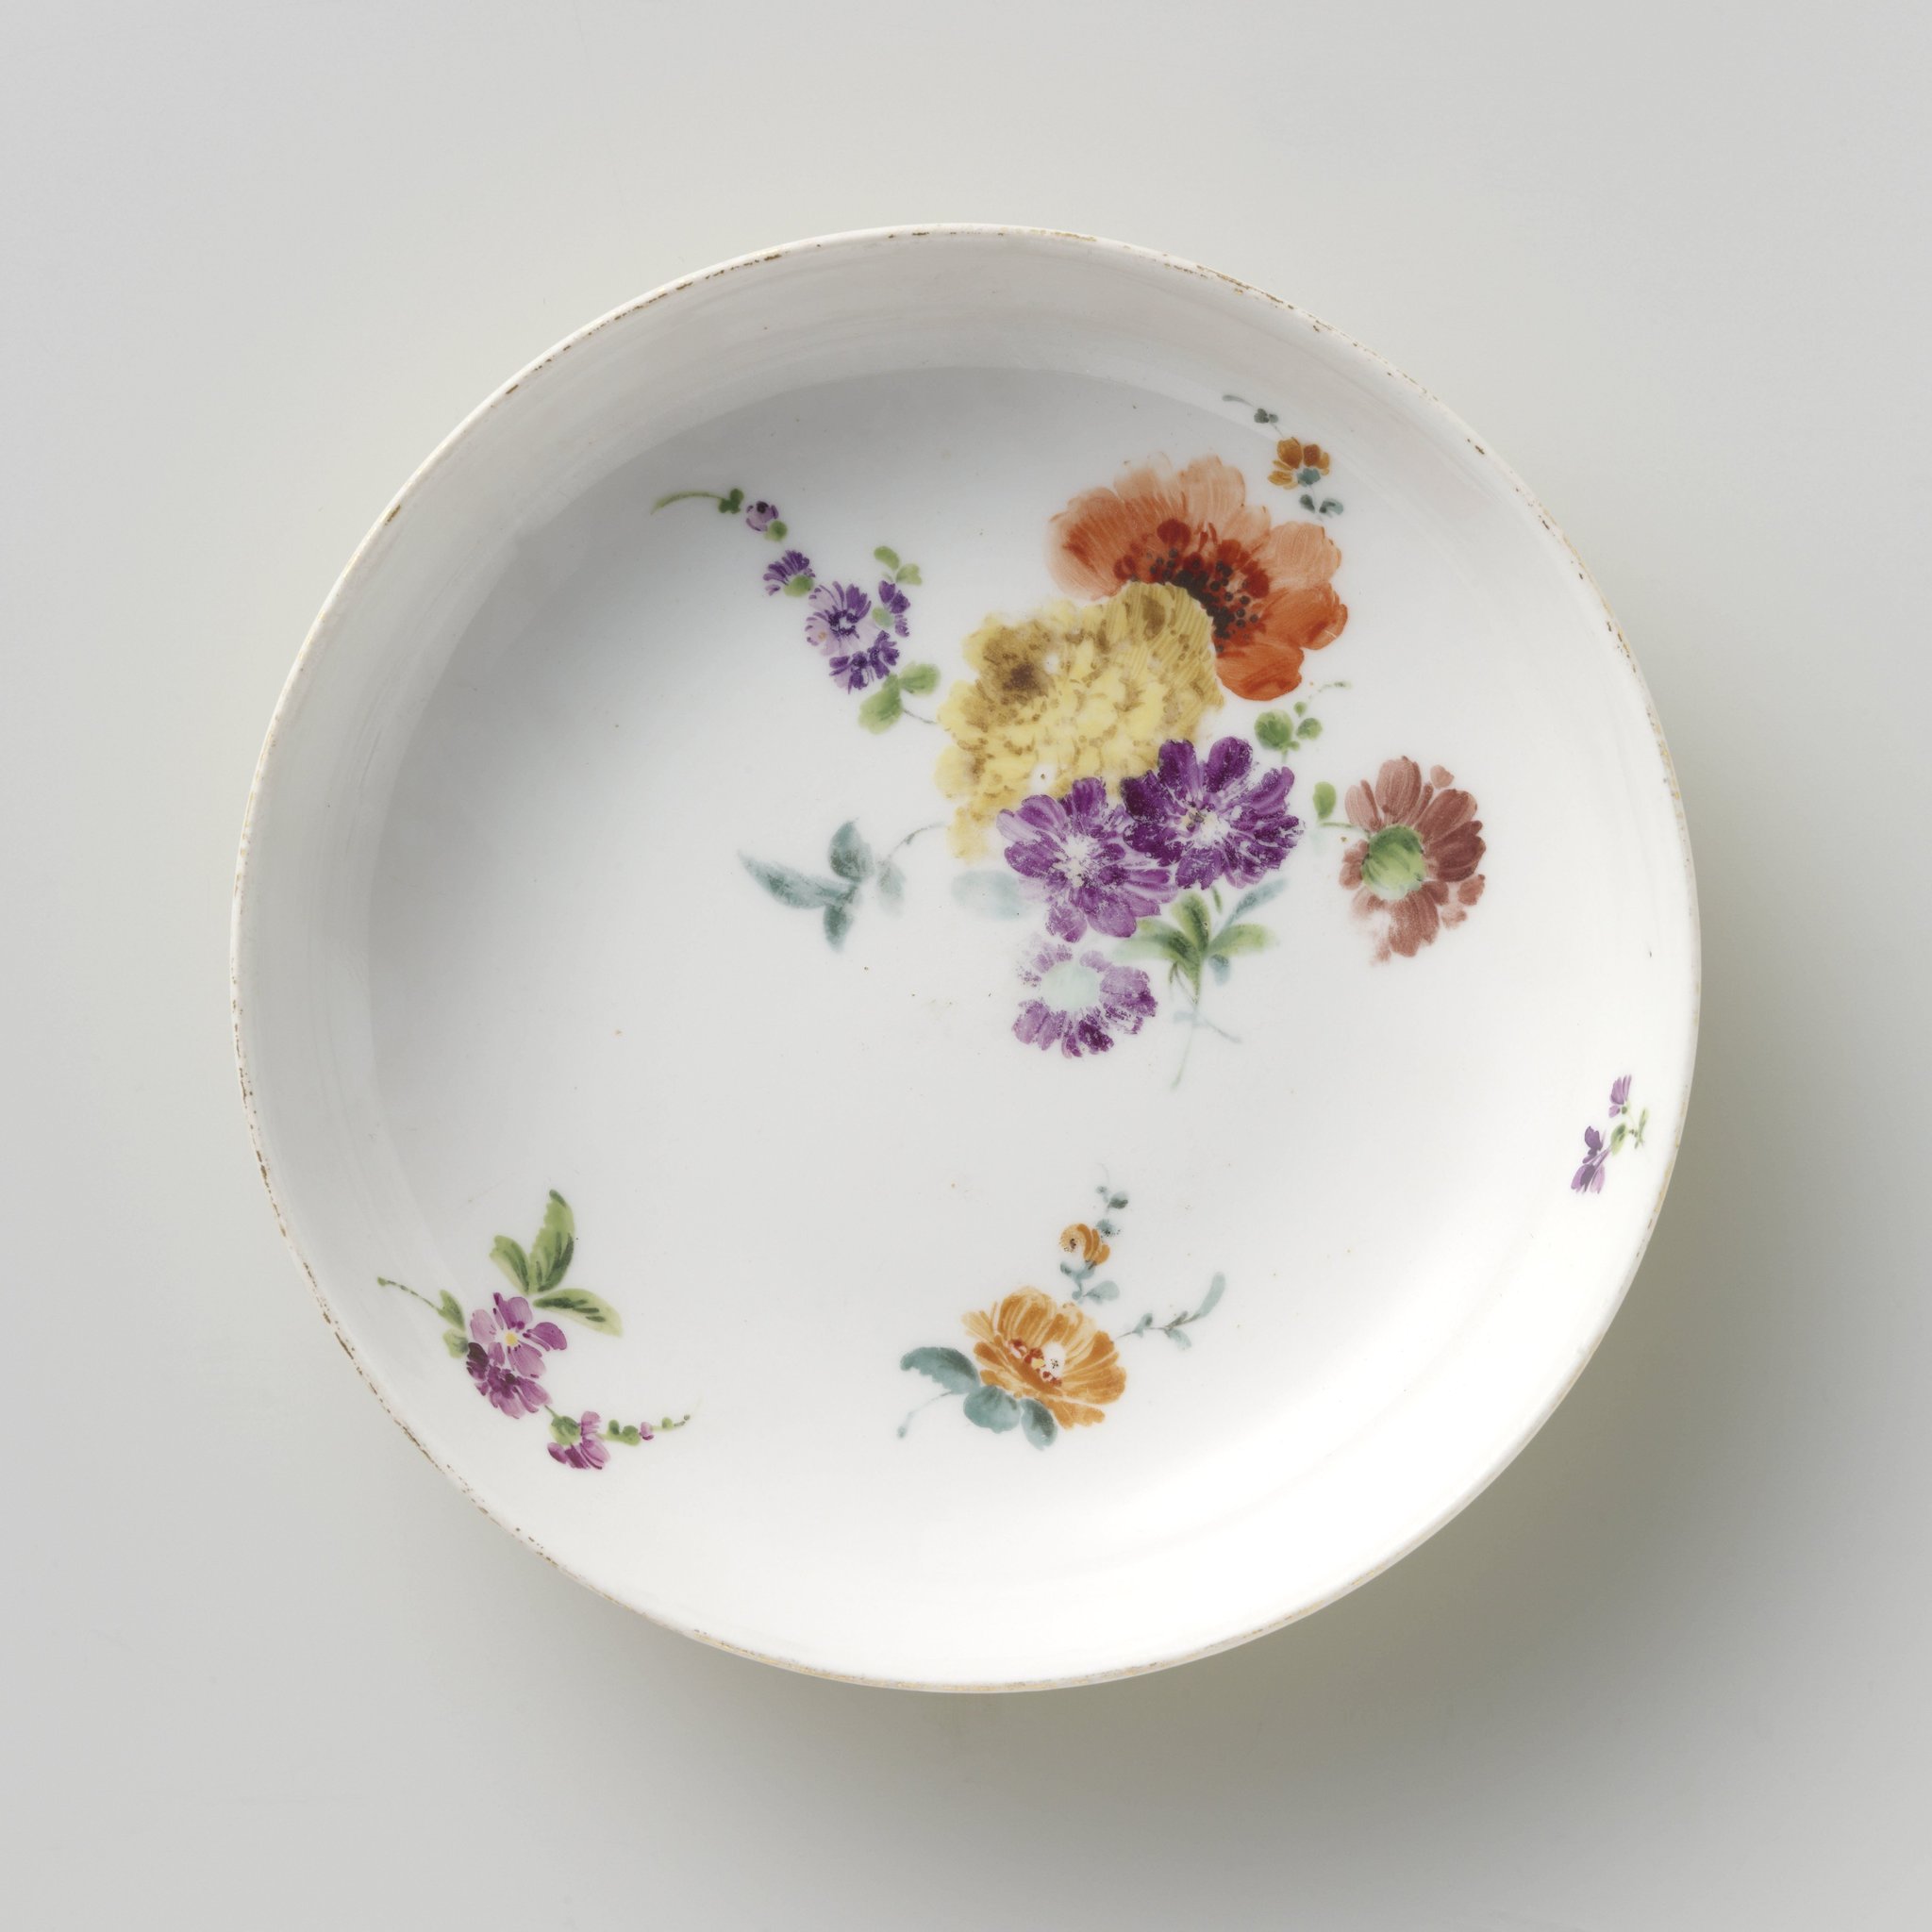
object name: eating drinking utensil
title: Schotel, veelkleurig beschilderd met Deutsche Blumen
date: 1765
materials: porcelain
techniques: painted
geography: meissen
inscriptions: factory mark, mold mark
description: Tea service. Porcelain. Meissen, c. 1770. Jonkvrouwe A.C.A.J. Clifford bequest, 1960.